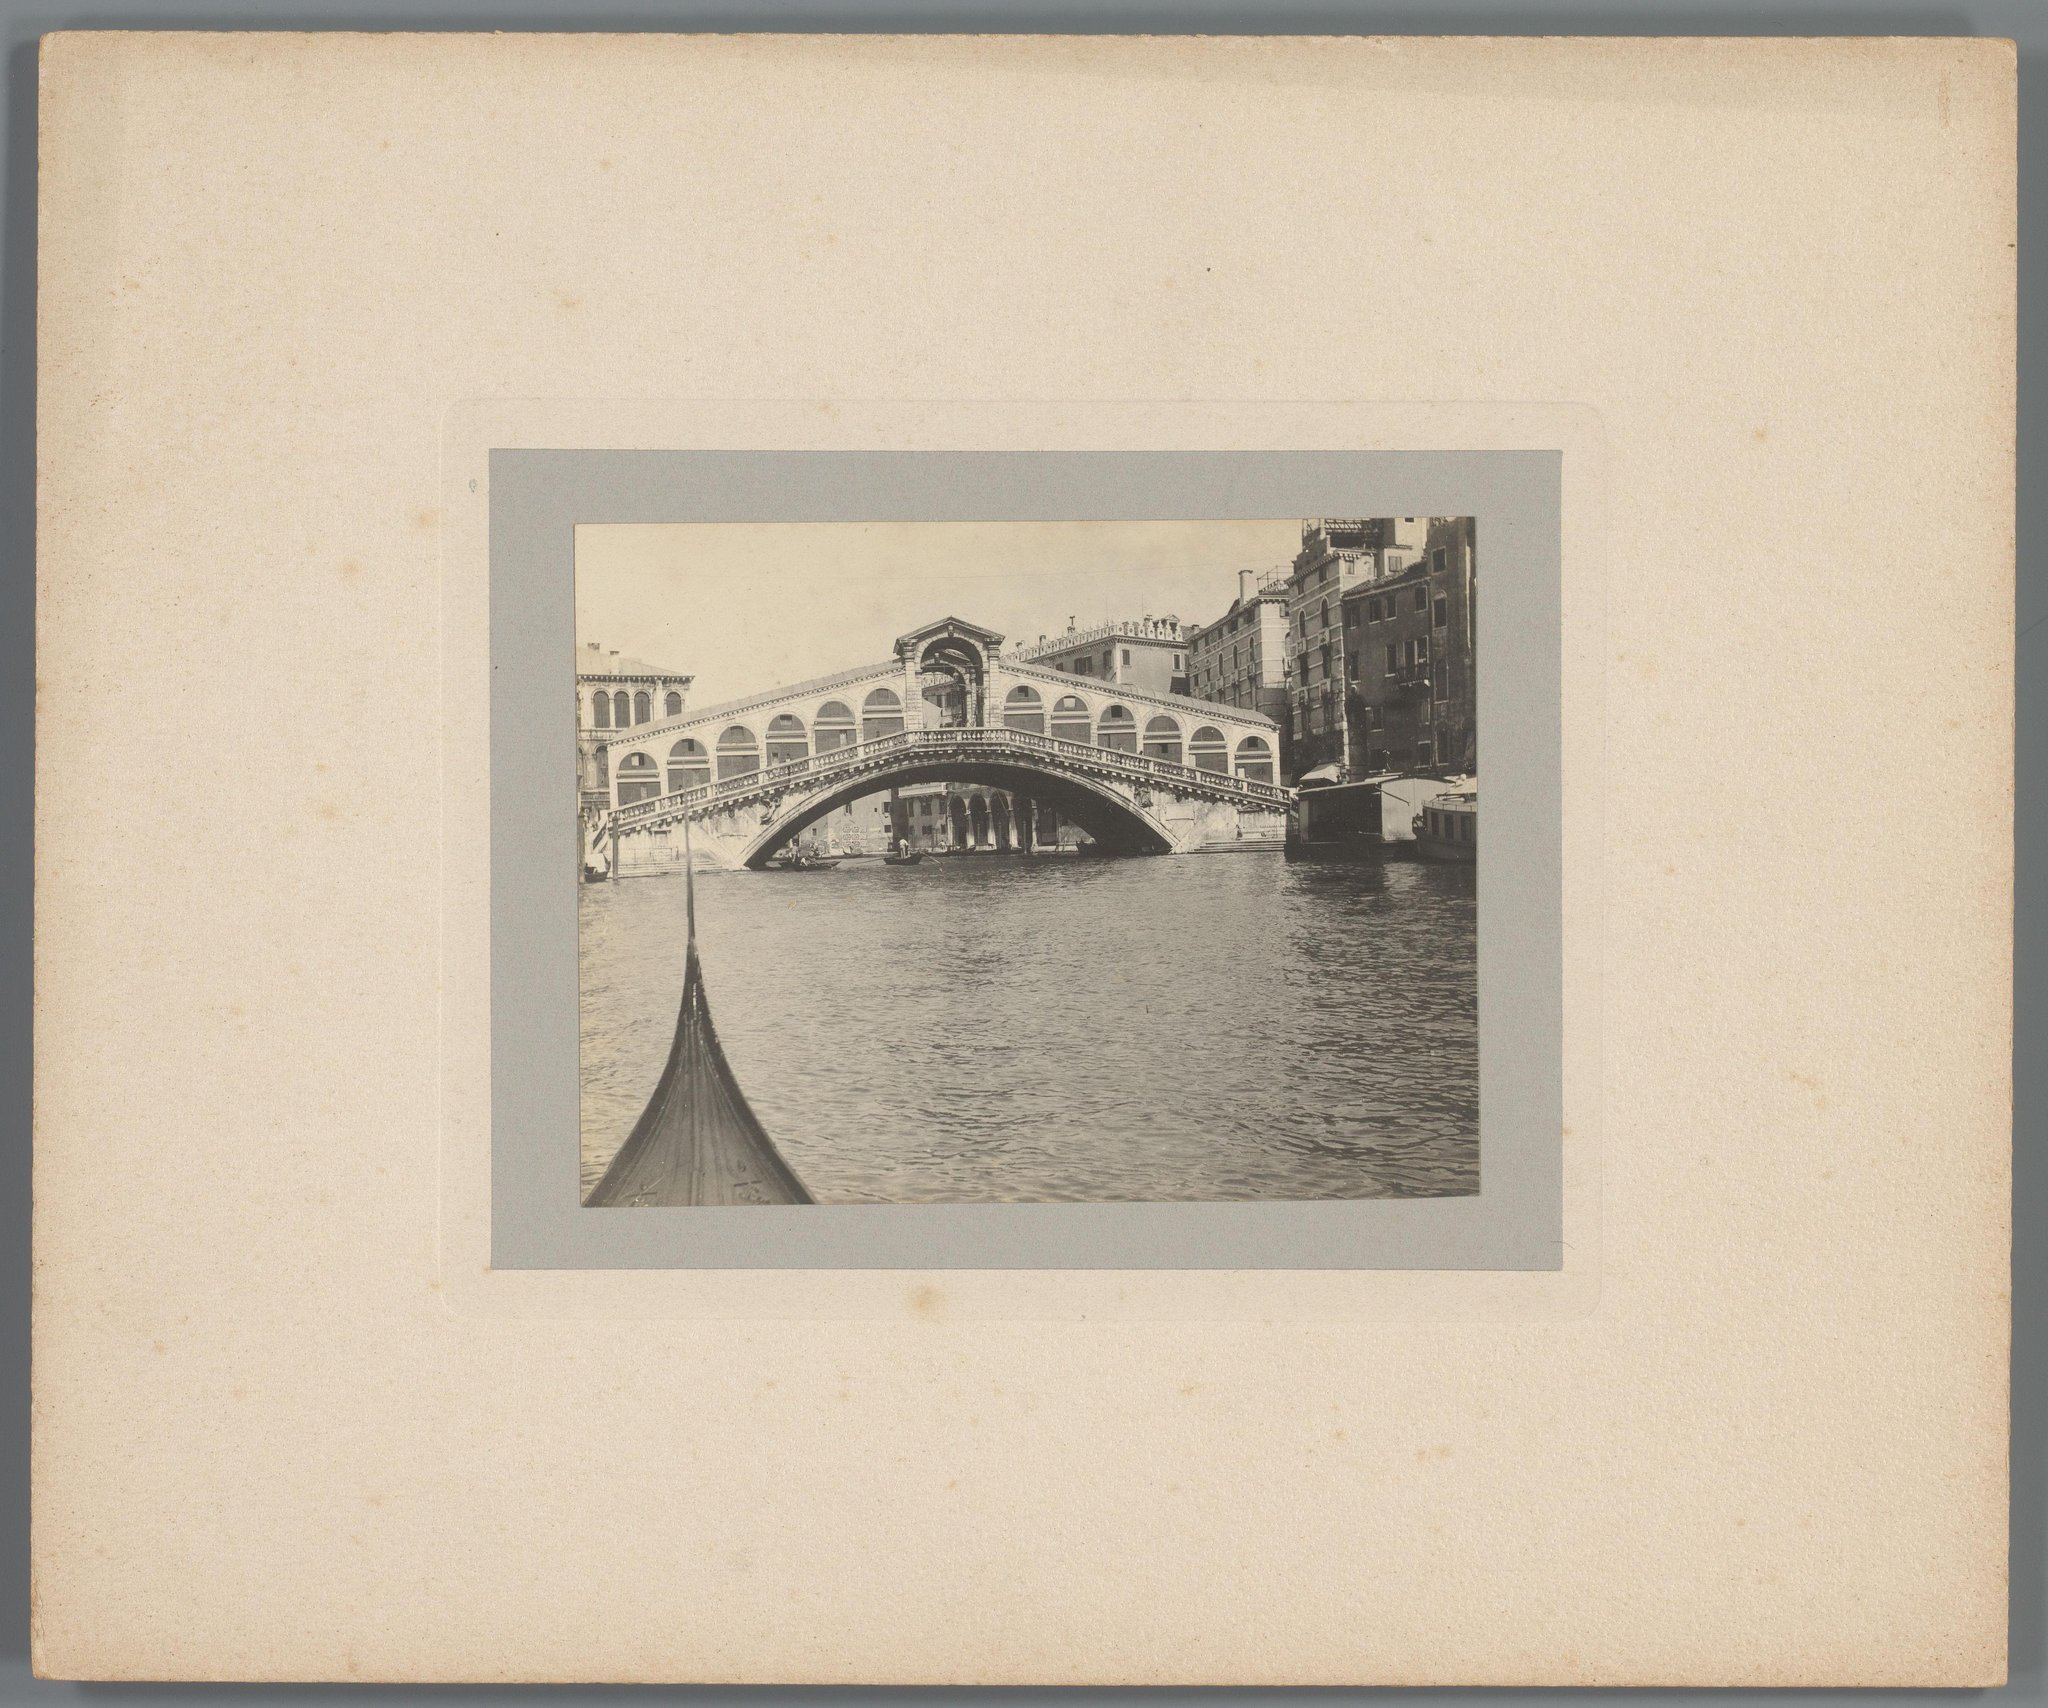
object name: photograph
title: Gezicht op de Rialtobrug, gezien vanuit een gondel, Venetië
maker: françois buys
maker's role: advocaat, amateurfotograaf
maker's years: 1871-1934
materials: paper, cardboard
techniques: gelatin silver print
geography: venice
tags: canals, waters (in city), bridge in city with structures, i.e. shops, houses, e.g. ponte vecchio in florence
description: Deze foto maakt deel uit van een groep van 38 foto's.